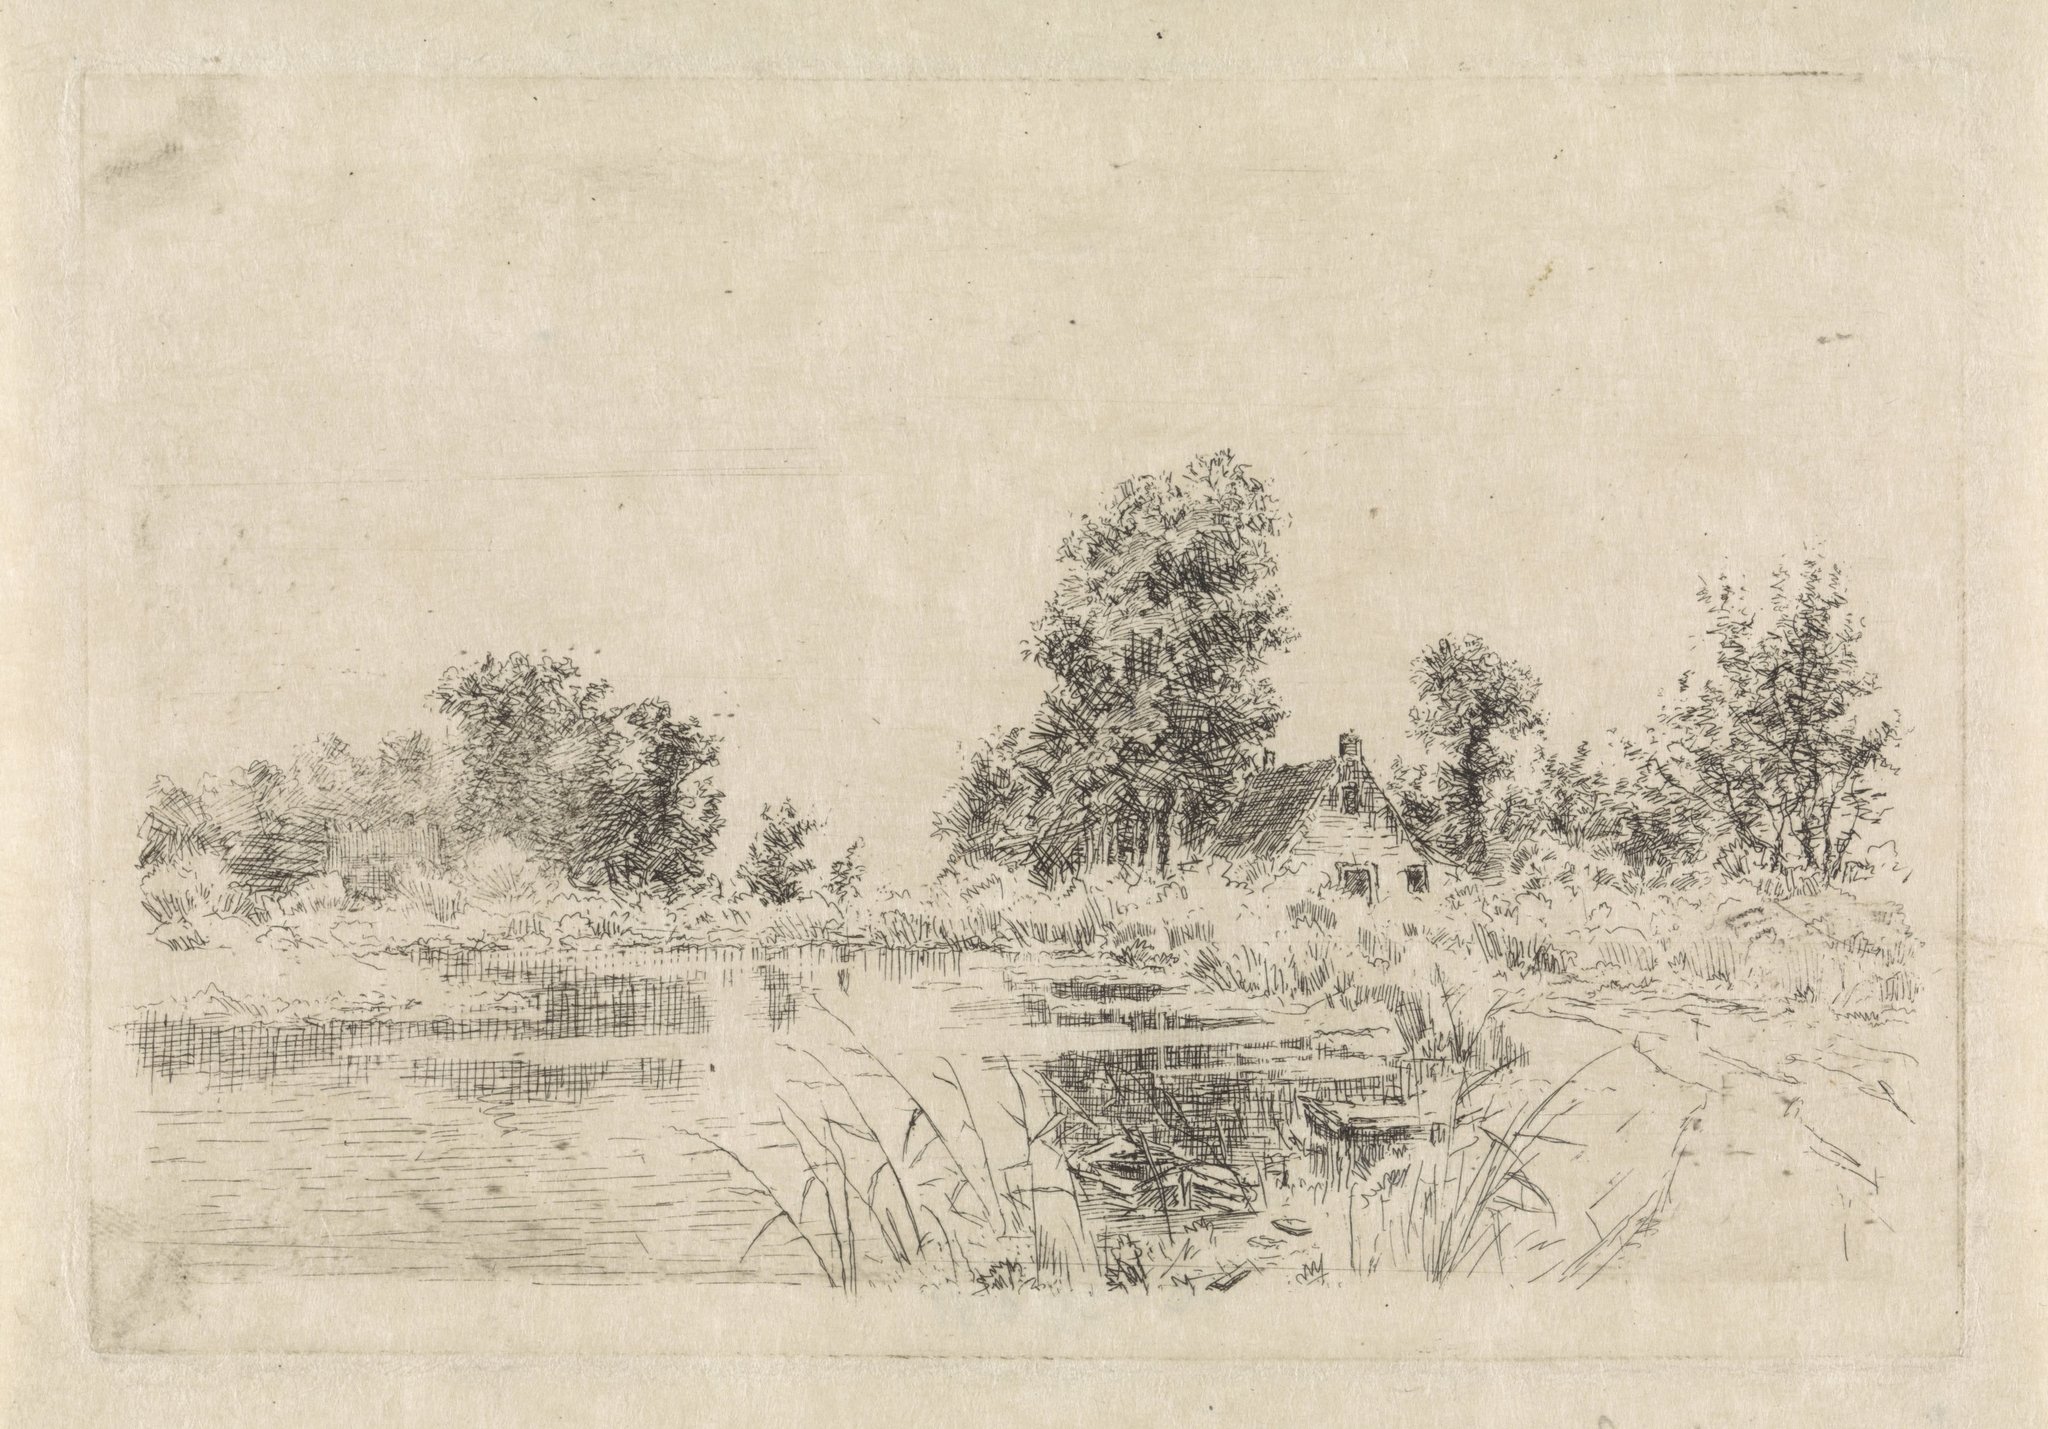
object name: print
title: Boerderij en bomen aan het water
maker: elias stark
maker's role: draughtsman, print maker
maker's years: 1849-1933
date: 1859-1933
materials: paper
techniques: etching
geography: netherlands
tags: farm or solitary house in landscape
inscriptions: collector's mark: Lugt 2228